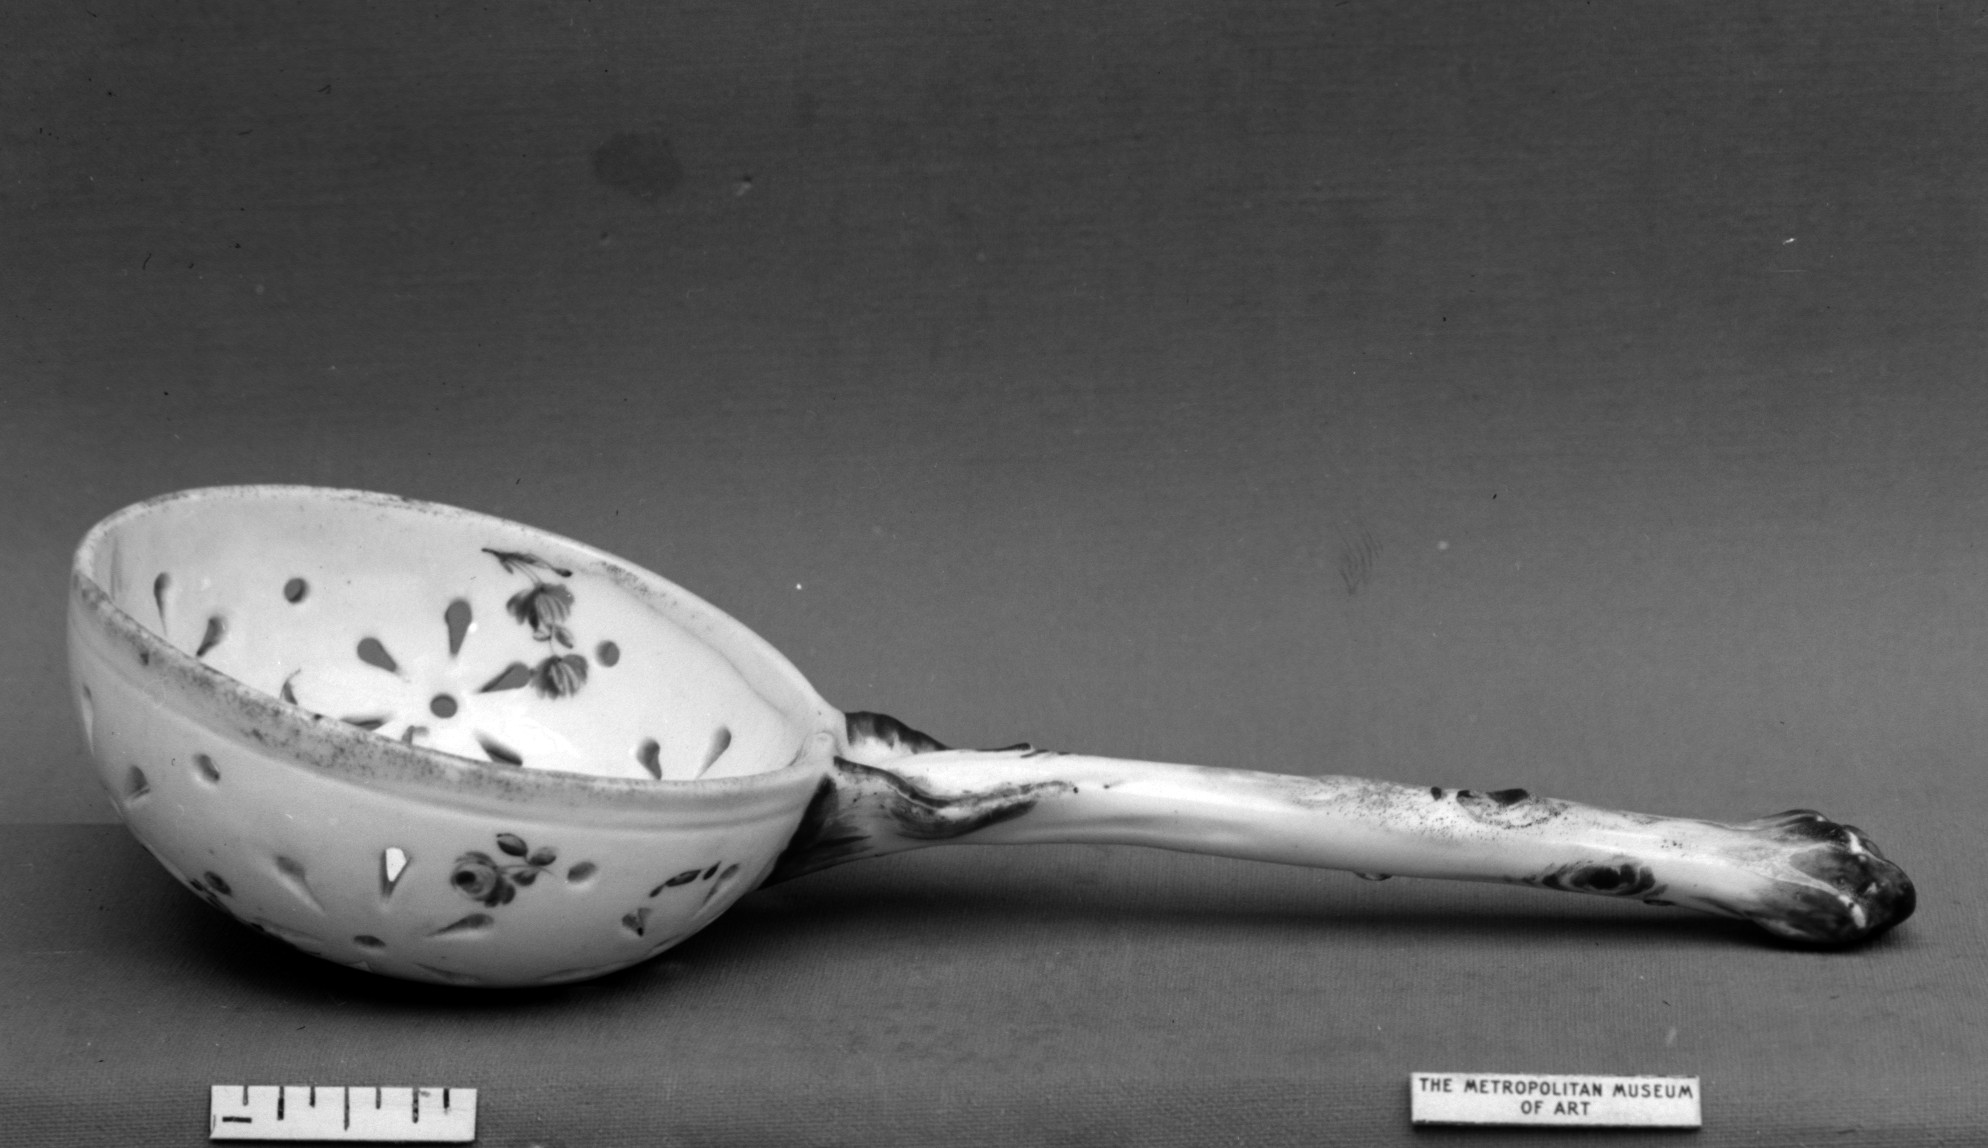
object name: sugar spoon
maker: mennecy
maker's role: factory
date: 1750-1760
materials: soft paste porcelain